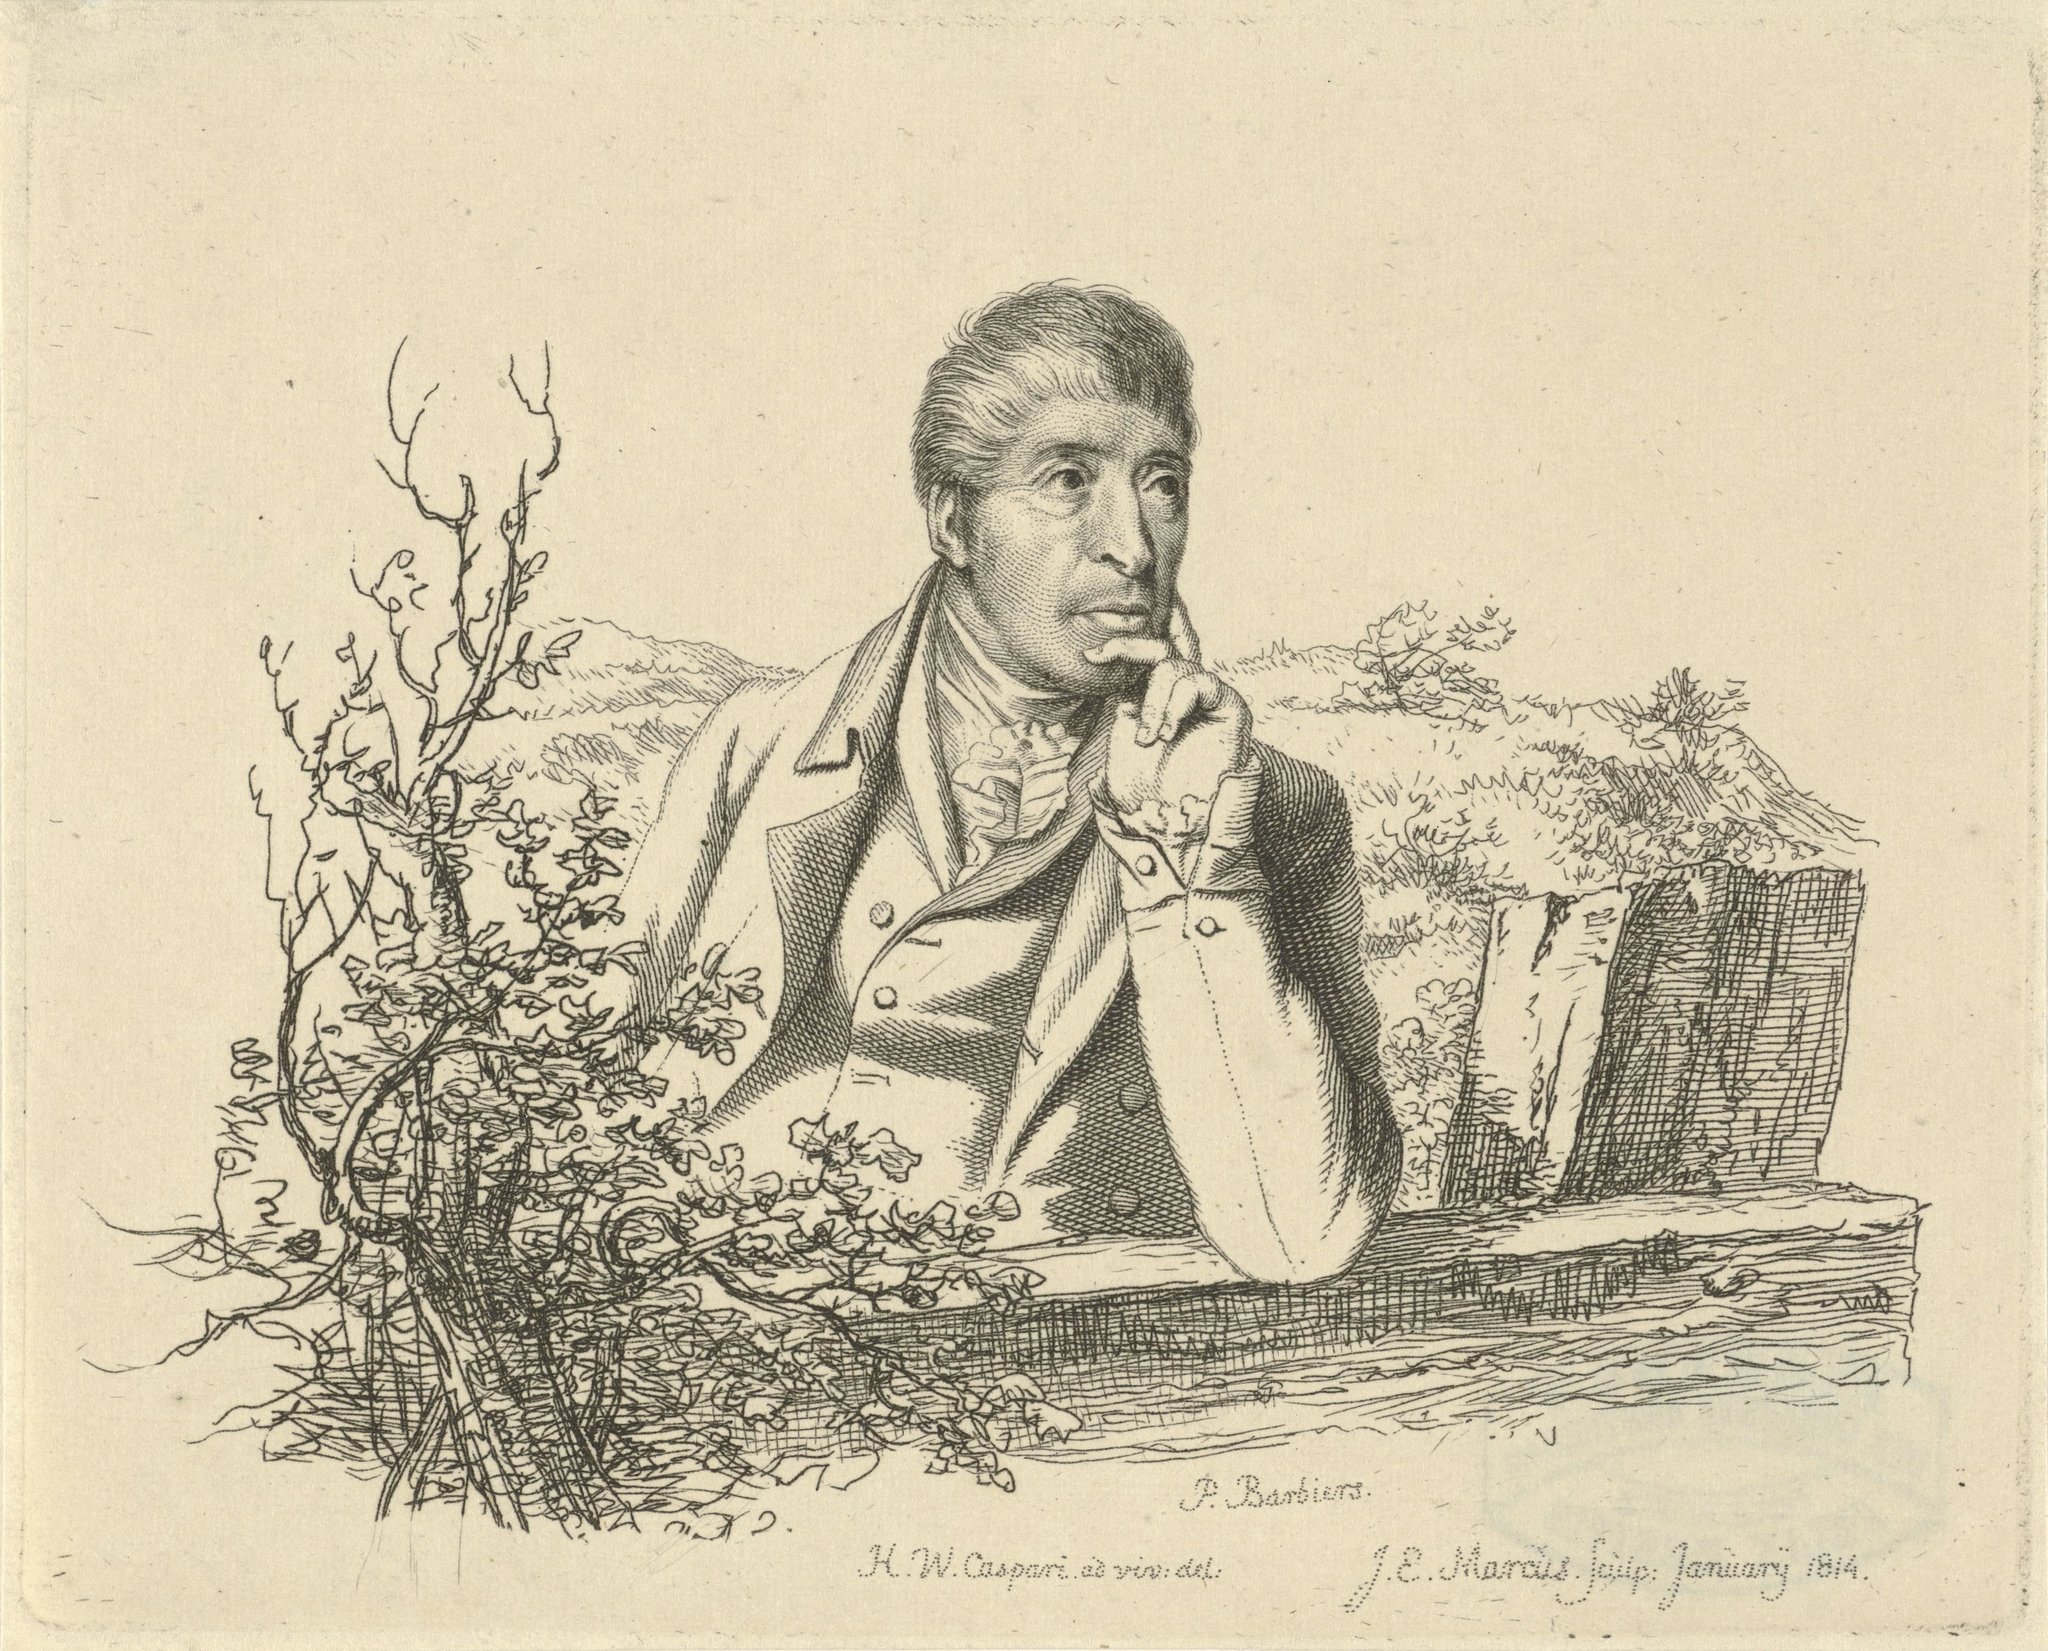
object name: print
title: Studie-prentwerk / Etudes gravées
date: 1814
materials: paper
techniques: etching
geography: amsterdam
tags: draughtsman, pieter pietersz. barbiers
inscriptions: collector's mark: Lugt 924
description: Serie voor het eerst uitgegeven door Jacob Ernst Marcus onder de titel Studiebeelden en Fragmenten. Amsterdam: ca.1816. Later heruitgegeven als: Studie-prentwerk/ Etudes gravées.